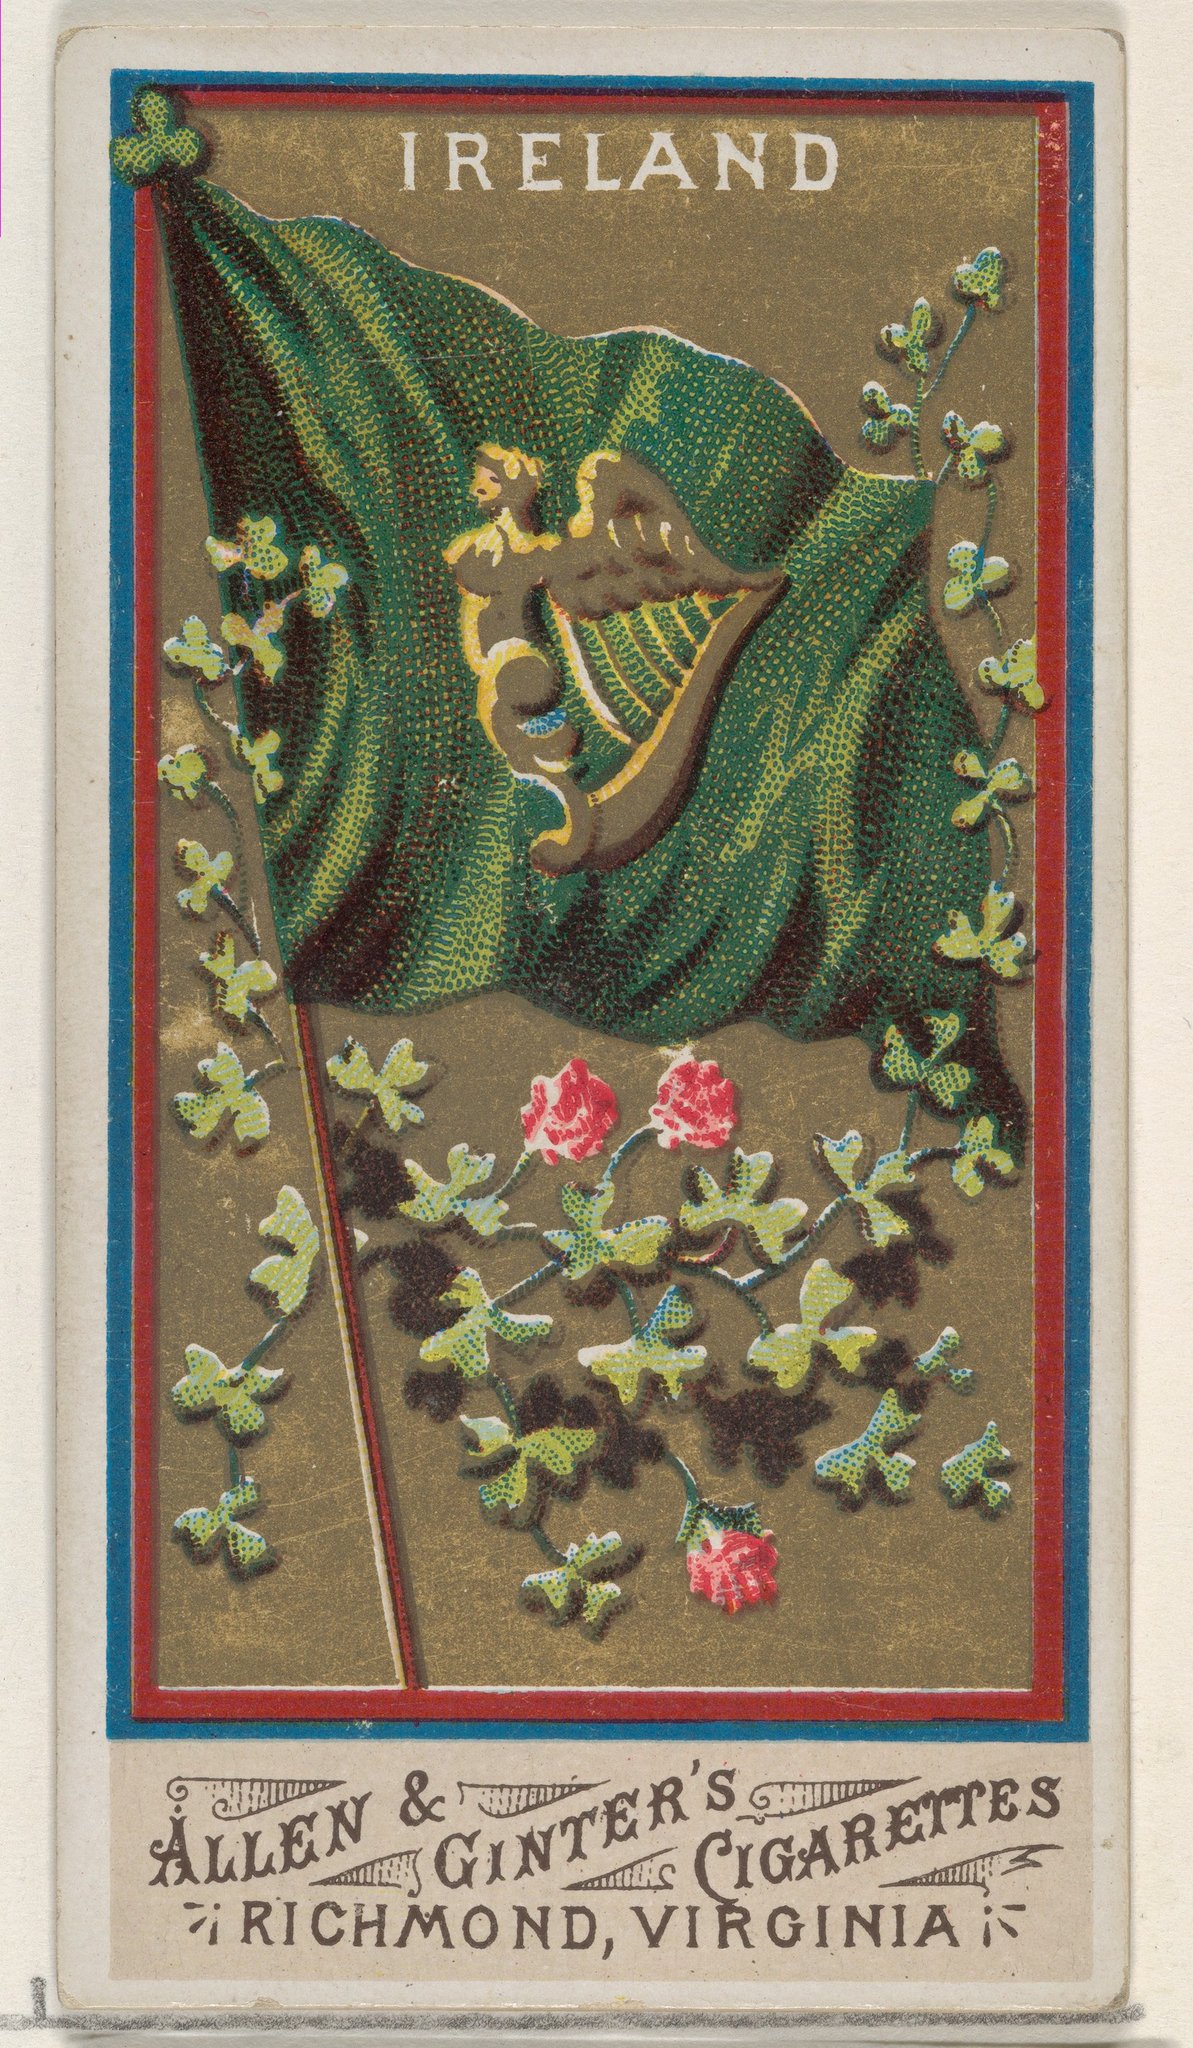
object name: print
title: Ireland, from Flags of All Nations, Series 1 (N9) for Allen & Ginter Cigarettes Brands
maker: allen & ginter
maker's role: publisher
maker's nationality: american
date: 1887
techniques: color lithograph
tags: flags